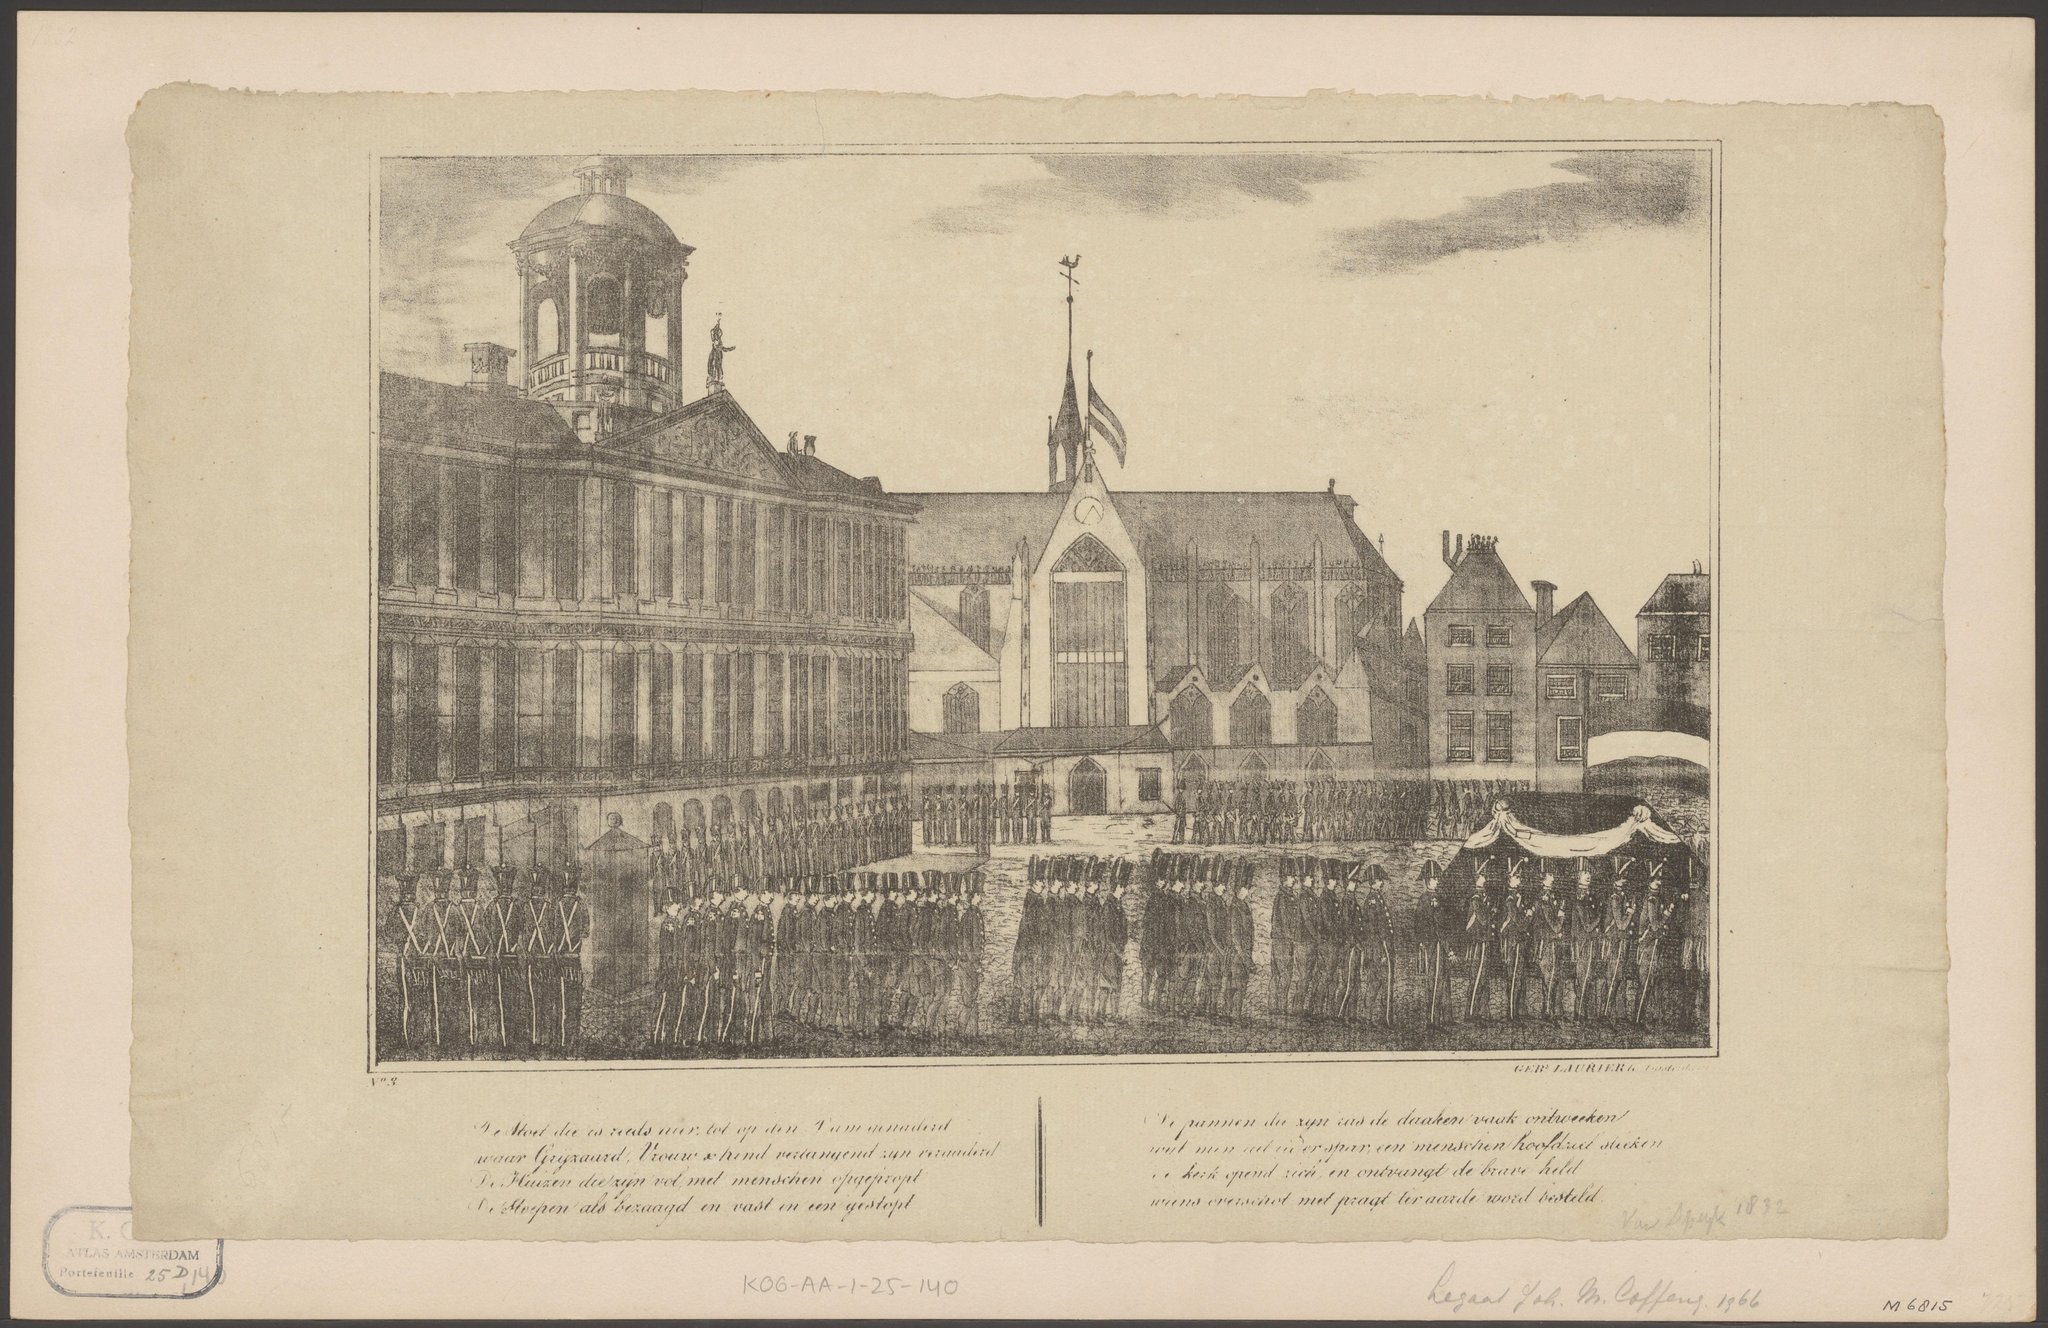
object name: print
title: Begrafenis van J.C.J. van Speyk in vier platen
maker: Anonymous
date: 1832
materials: paper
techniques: lithograph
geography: amsterdam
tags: amsterdam, antwerp, jan van speyk, cortege, funeral procession, commander-in-chief, admiral, historical person (with name), royal palace of amsterdam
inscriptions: collector's mark: ‘25D.140’ Lugt 1641b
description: Rechtsonder genummerd: No 3. Derde plaat in een serie van vier platen van de begrafenis van Jan van Speyk te Amsterdam op 4 met 1832. Onderwerpsrubriek binnen de Atlas Amsterdam: Krijgswezen I: De Admiraliteit van Amsterdam, D. J.C. van Speyk.